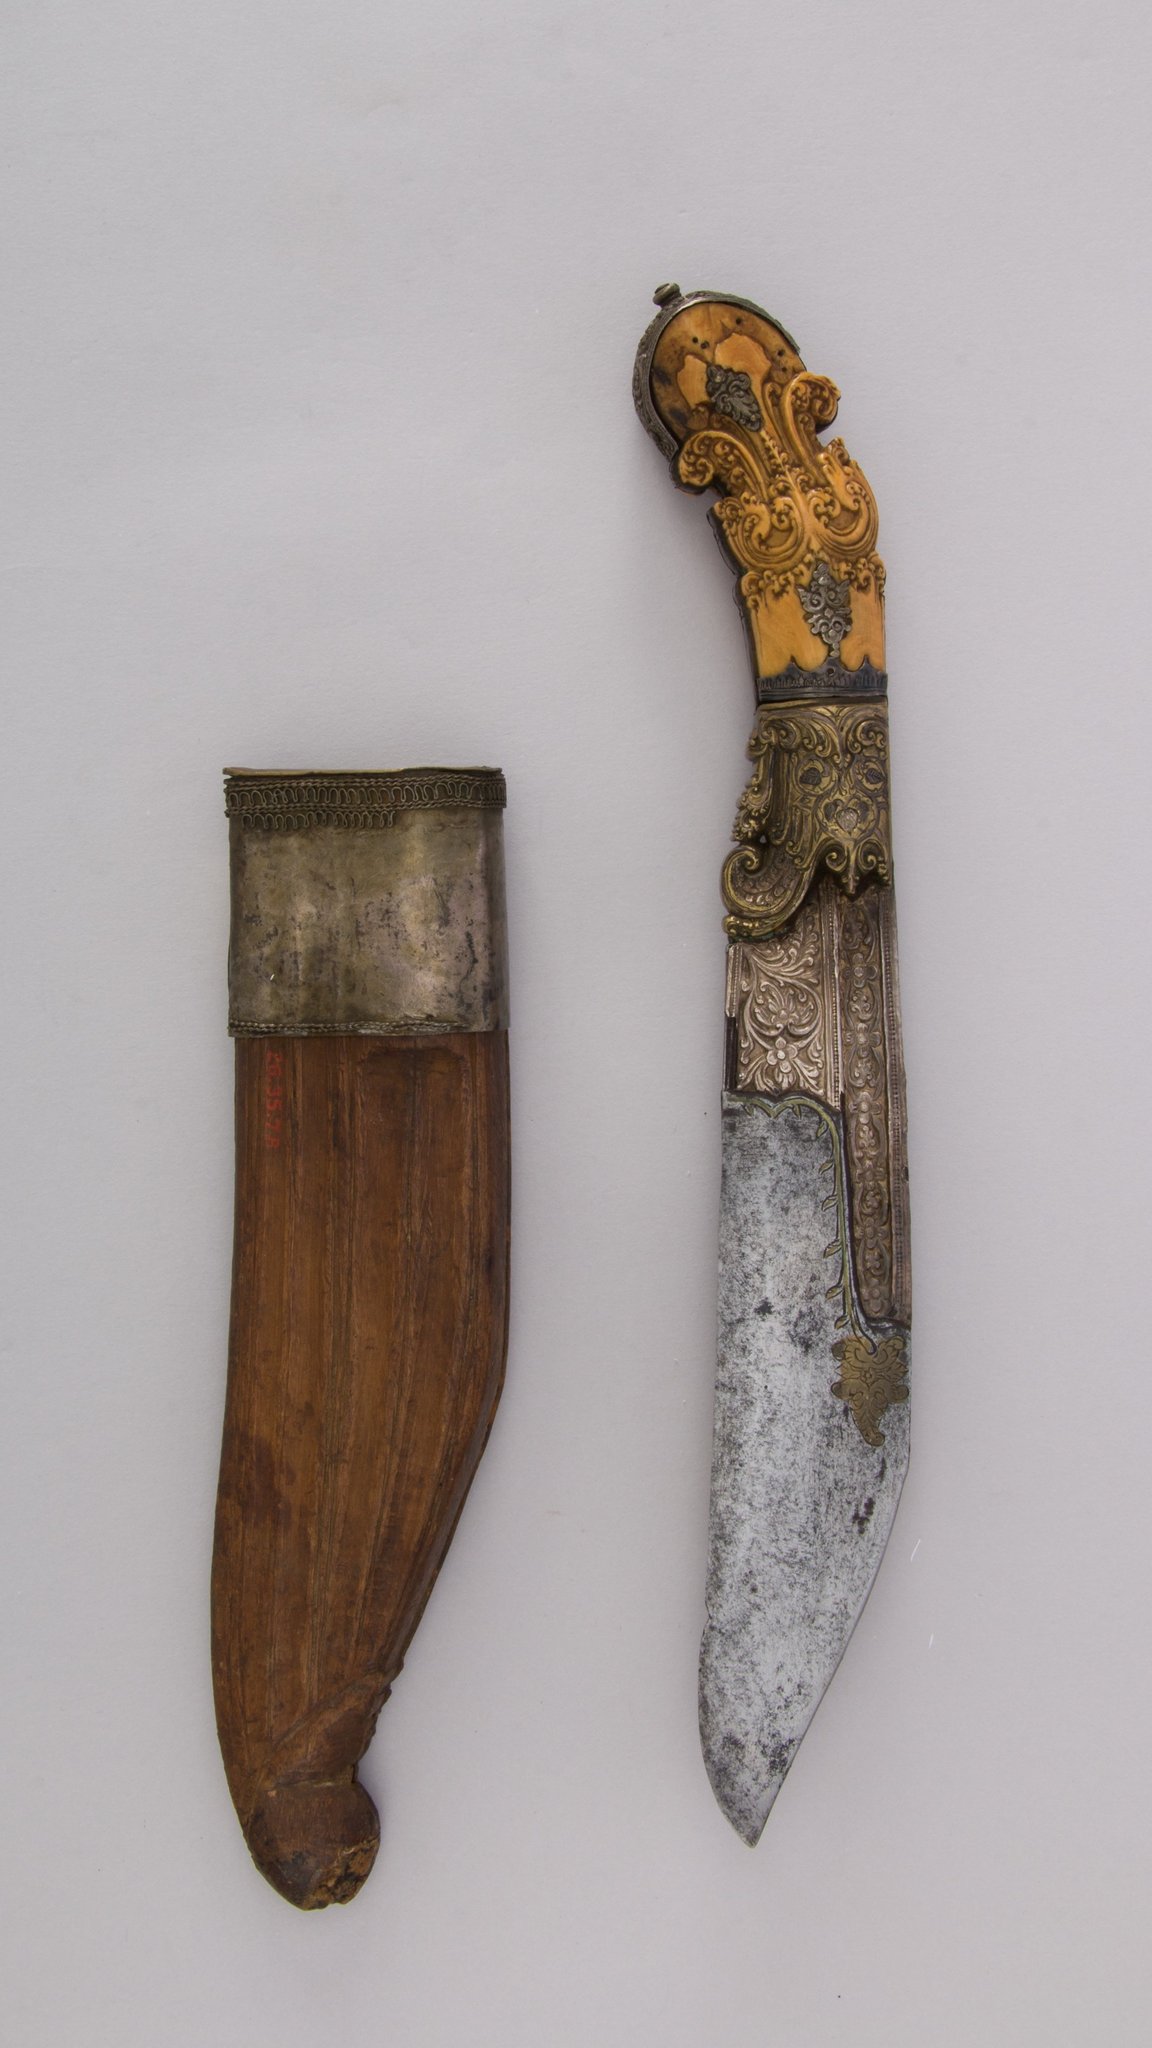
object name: dagger piha kaetta with sheath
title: Dagger (Piha Kaetta) with Sheath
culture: sri lankan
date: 1701-1800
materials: brass, ivory, silver, steel, wood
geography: sri lanka